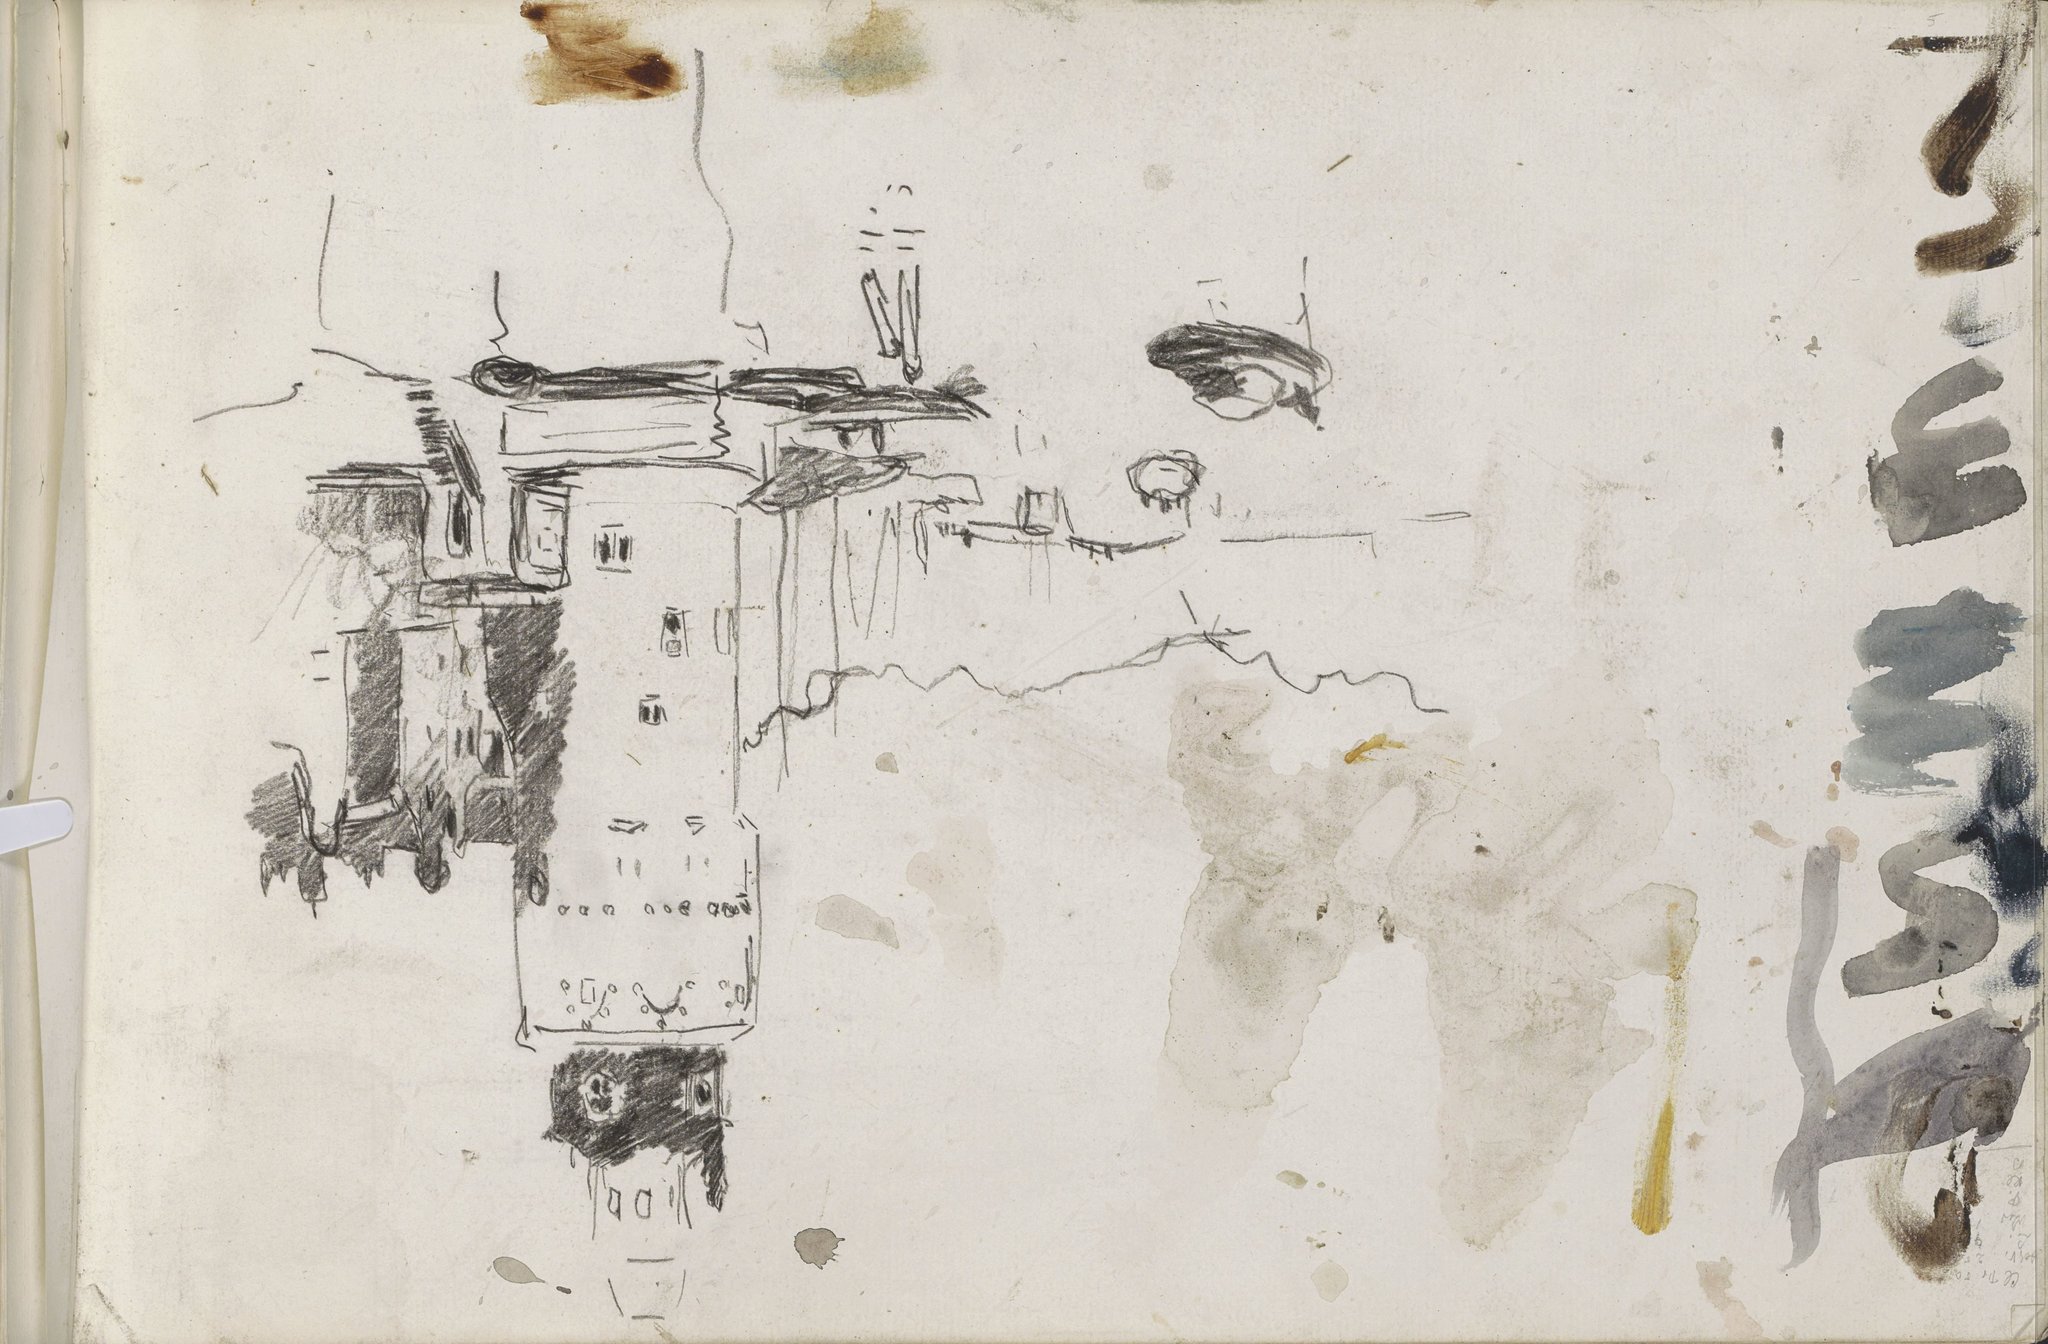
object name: sketchbook leaf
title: Oudeschans met de Montelbaanstoren, gezien vanaf de Kikkerbilsluis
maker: willem witsen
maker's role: draughtsman, painter, print maker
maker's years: 1860-1923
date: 1887-1892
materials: chalk, paper, watercolor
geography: amsterdam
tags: urban housing, canals, waters (in city)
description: Pagina 5 uit een schetsboek met 17 bladen.